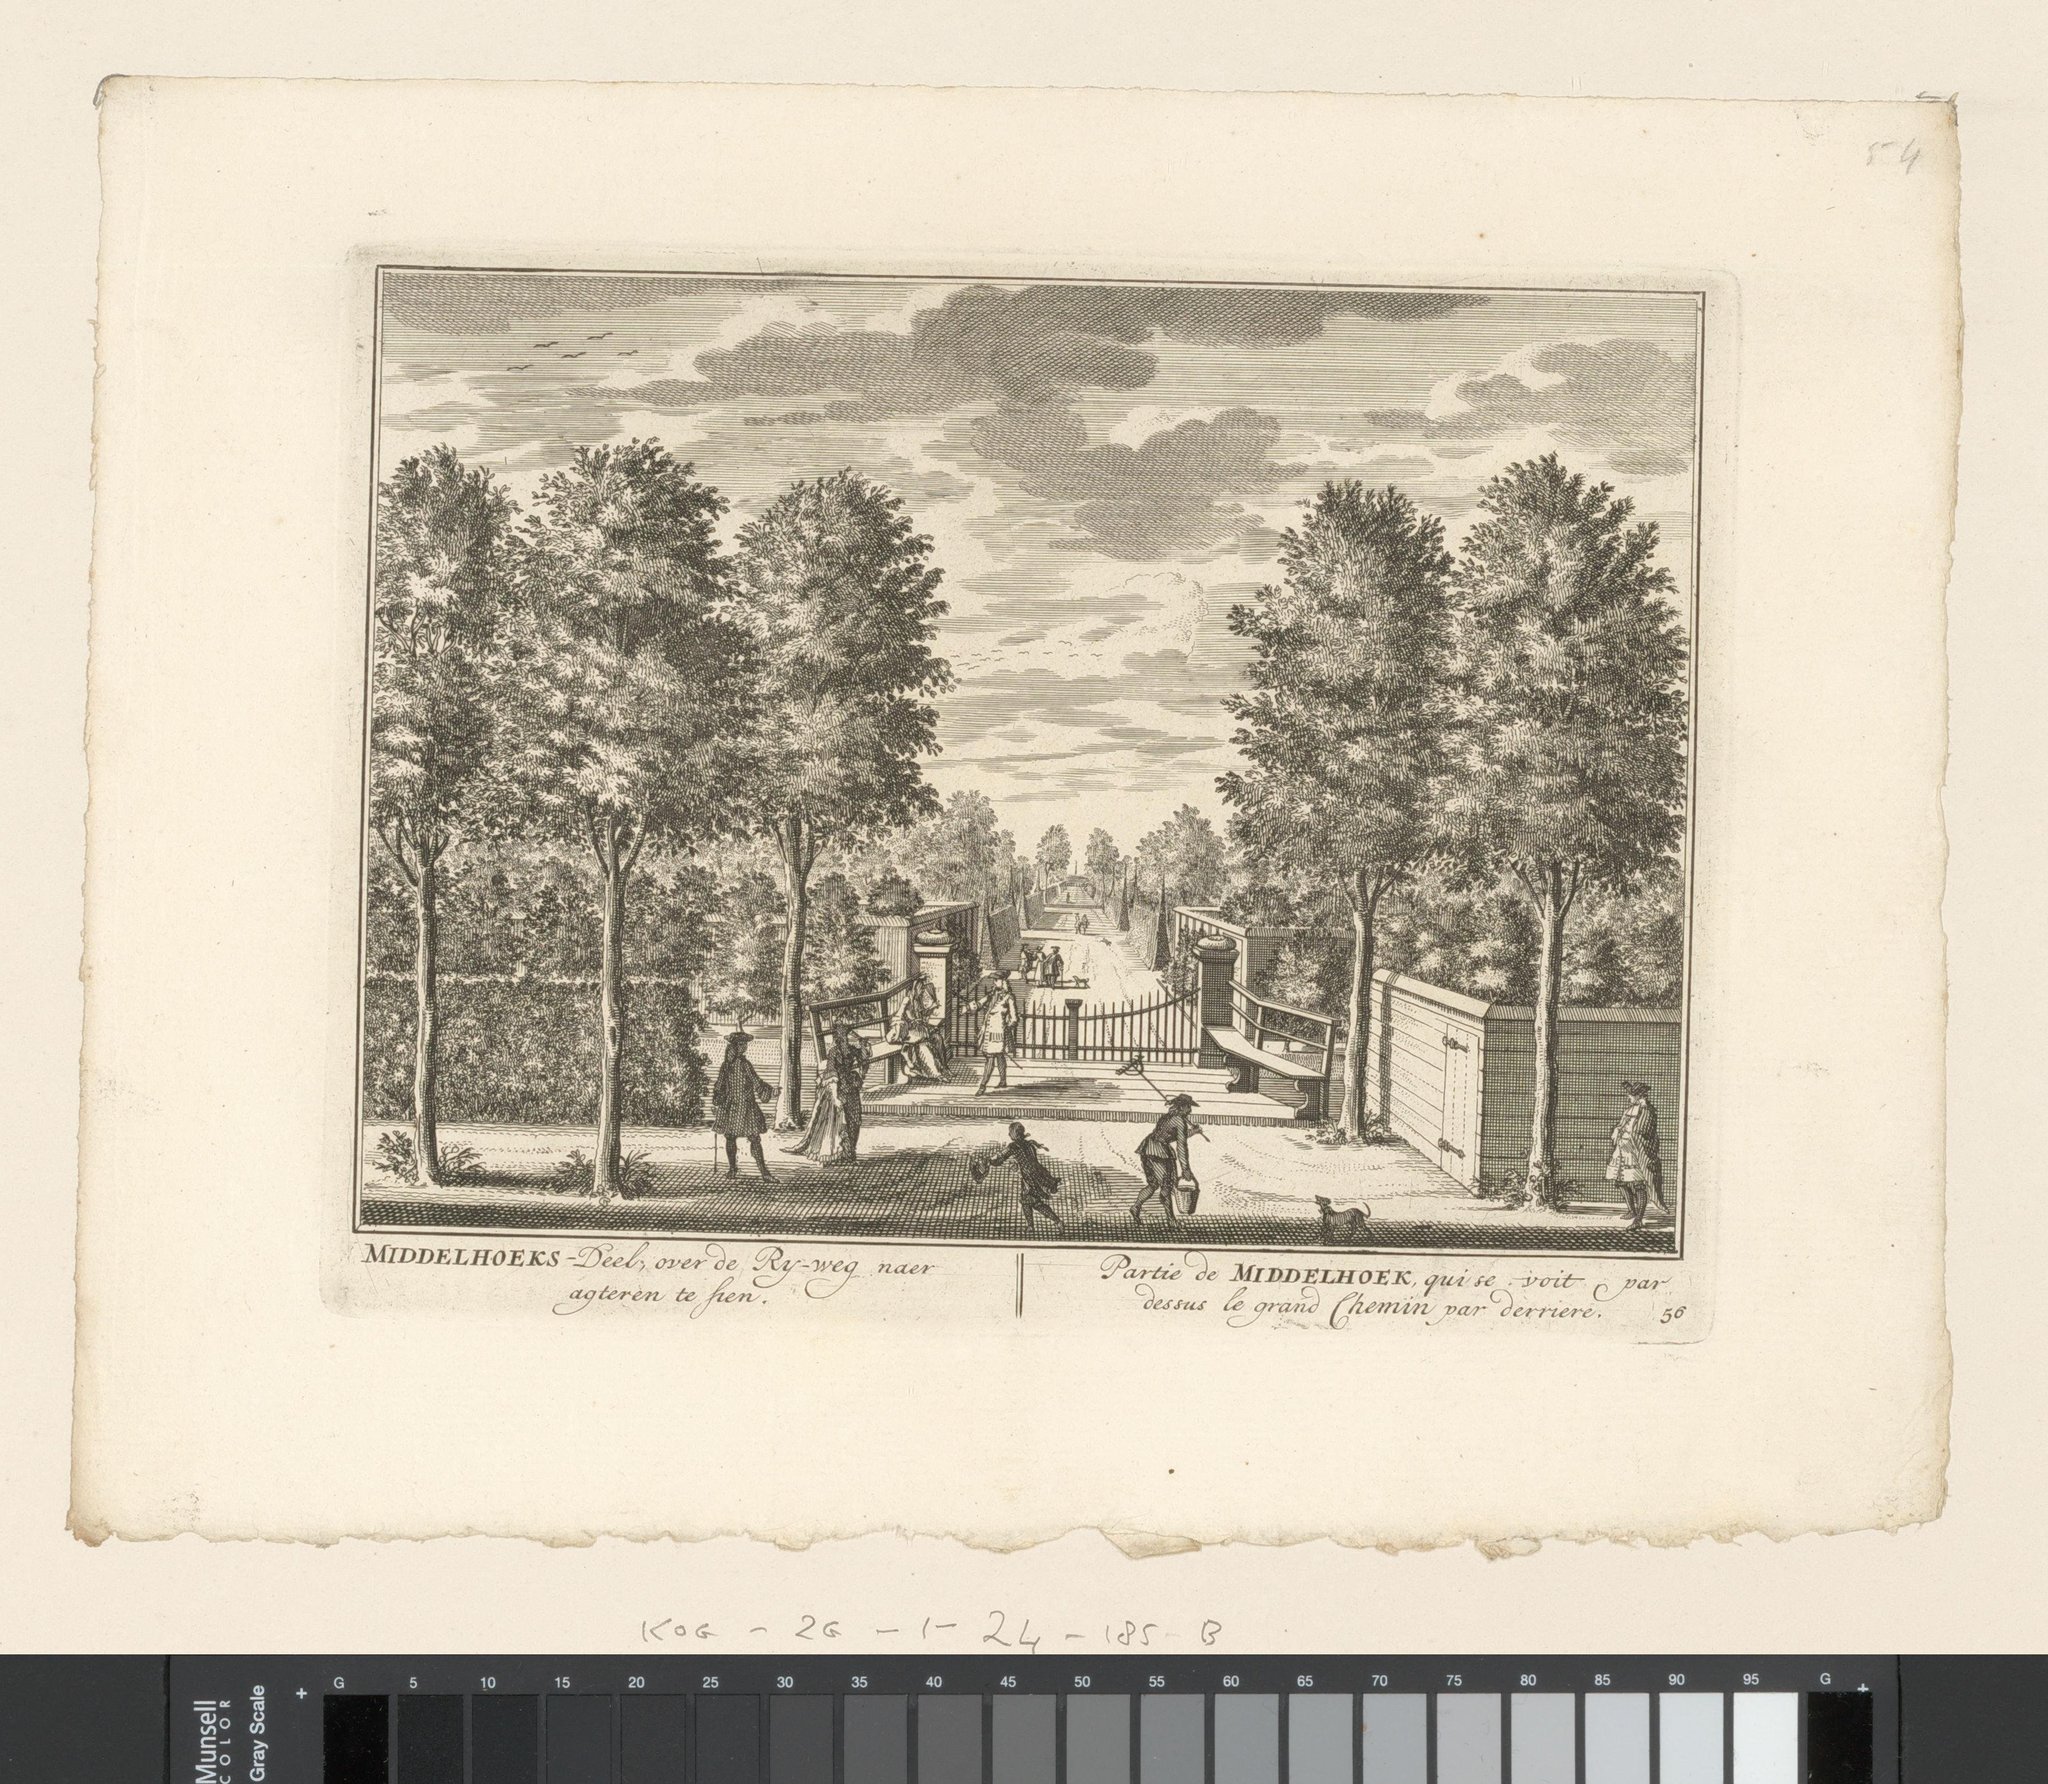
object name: print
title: Gezicht op Buitenplaats Middenhoek van de rijweg gezien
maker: hendrik de leth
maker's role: draughtsman, print maker, publisher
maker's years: 1703-1766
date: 1729-1732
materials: paper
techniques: engraving, etching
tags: french or architectonic garden; formal garden, country-house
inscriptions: stamp, collector's mark: Lugt 1641, stamp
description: Prent mogelijk uit: Brouërius van Nidek, Matthaeus. Het zegepralend Kennemerland, vertoond in 100 heerlyke gezichten. Amsterdam: Jan Roman, s.a. Of uit: Brouërius van Nidek, Matthaeus. Het zegepralend Kennemerland, vertoond in veele heerlyke gezichten. Amsterdam: Andries en Hendrik de Leth, s.a [1729-1732]. Of uit: Brouërius van Nidek, Matthaeus. Het zegepralend Kennemerland, vertoond in veele heerlyke gezichten. Amsterdam: Jan Roman, s.a.